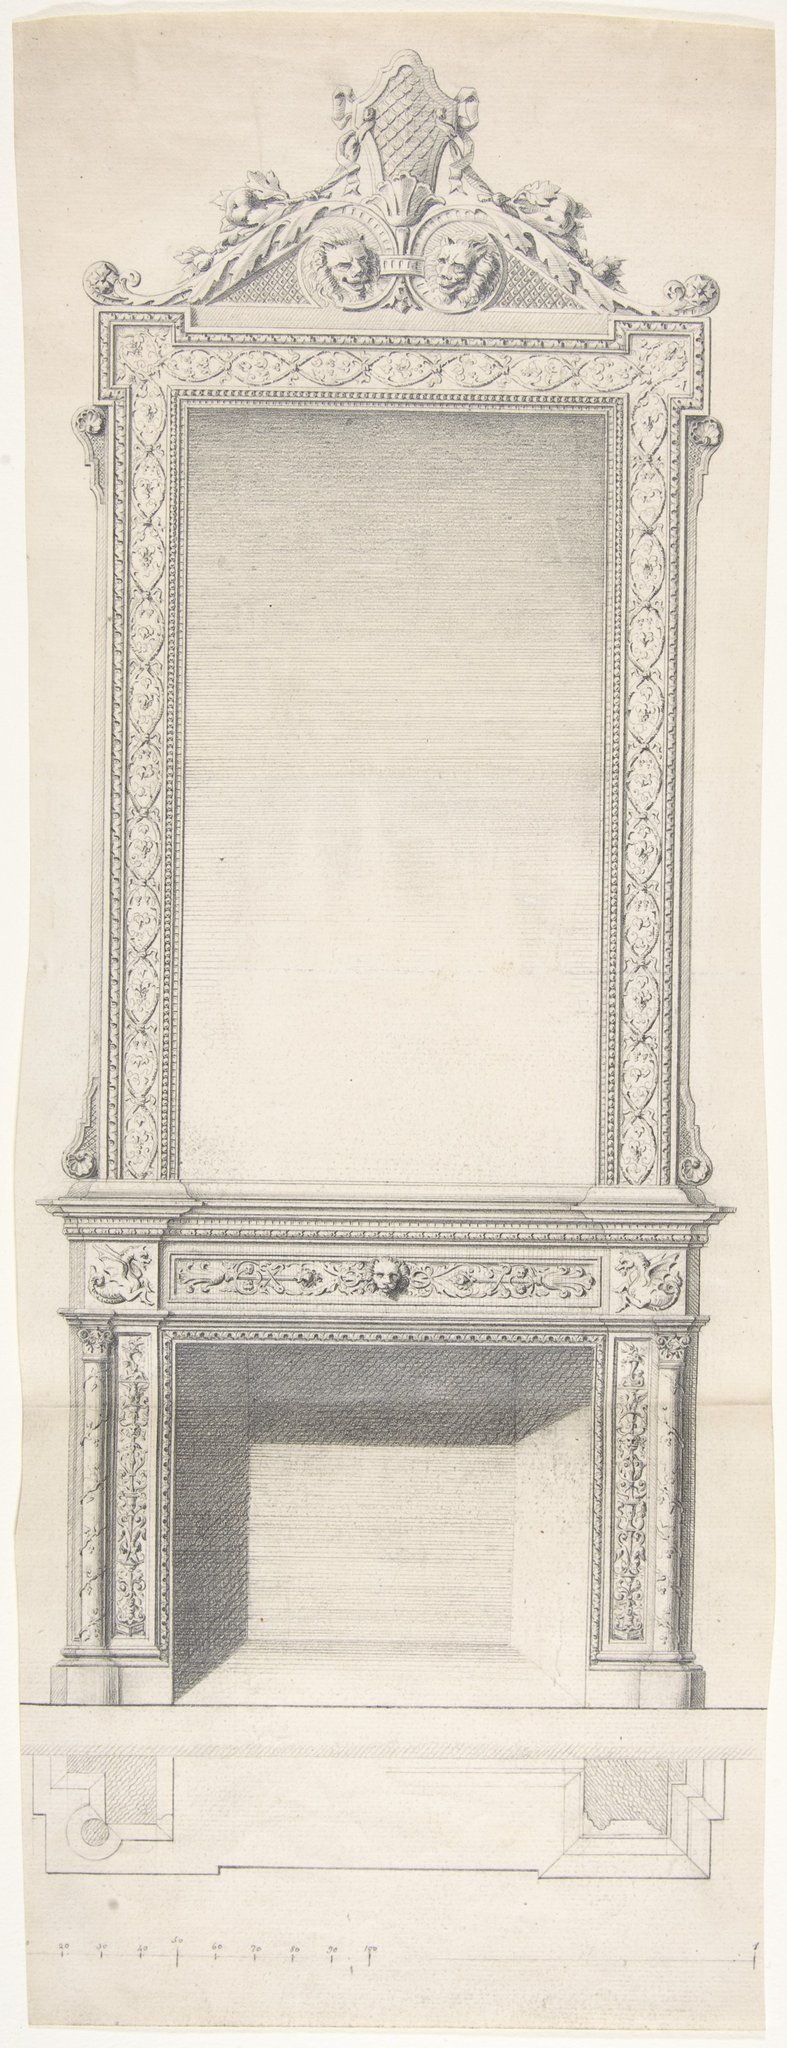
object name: drawing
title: Chimneypiece Design with Mirror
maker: anonymous, british, 19th century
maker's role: artist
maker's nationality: british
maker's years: 1800-1900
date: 1801-1900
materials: graphite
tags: fireplaces,mirrors